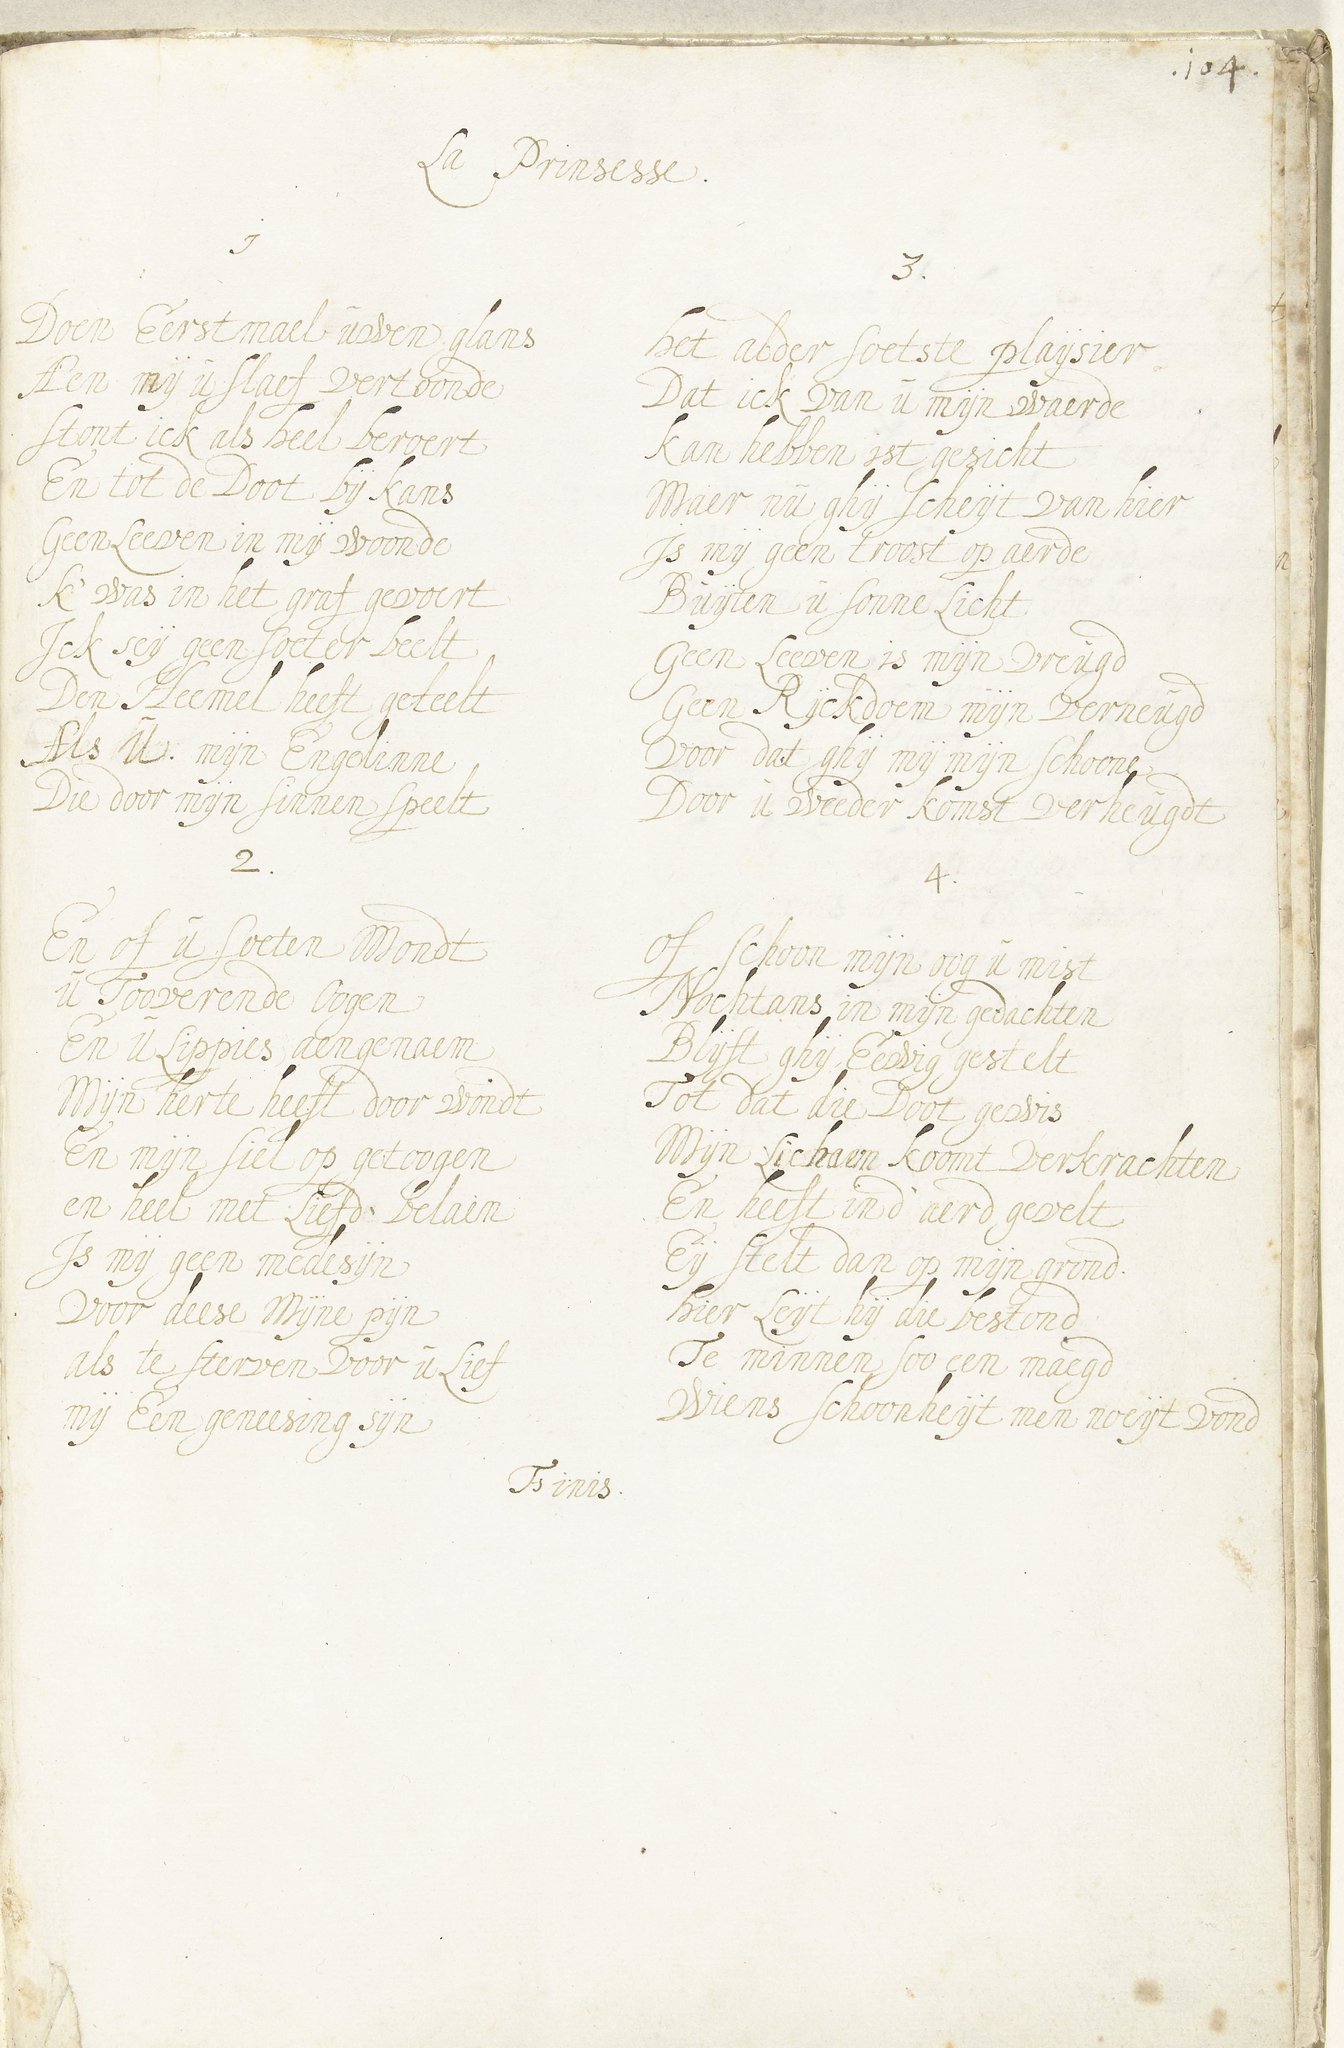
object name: poem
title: Liefdesklacht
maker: gesina ter borch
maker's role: draughtsman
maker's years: 1633-1690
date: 1659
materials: ink, paper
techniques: calligraphy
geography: zwolle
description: Liefdesklacht van vier coupletten, op de melodie van La Prinsesse.